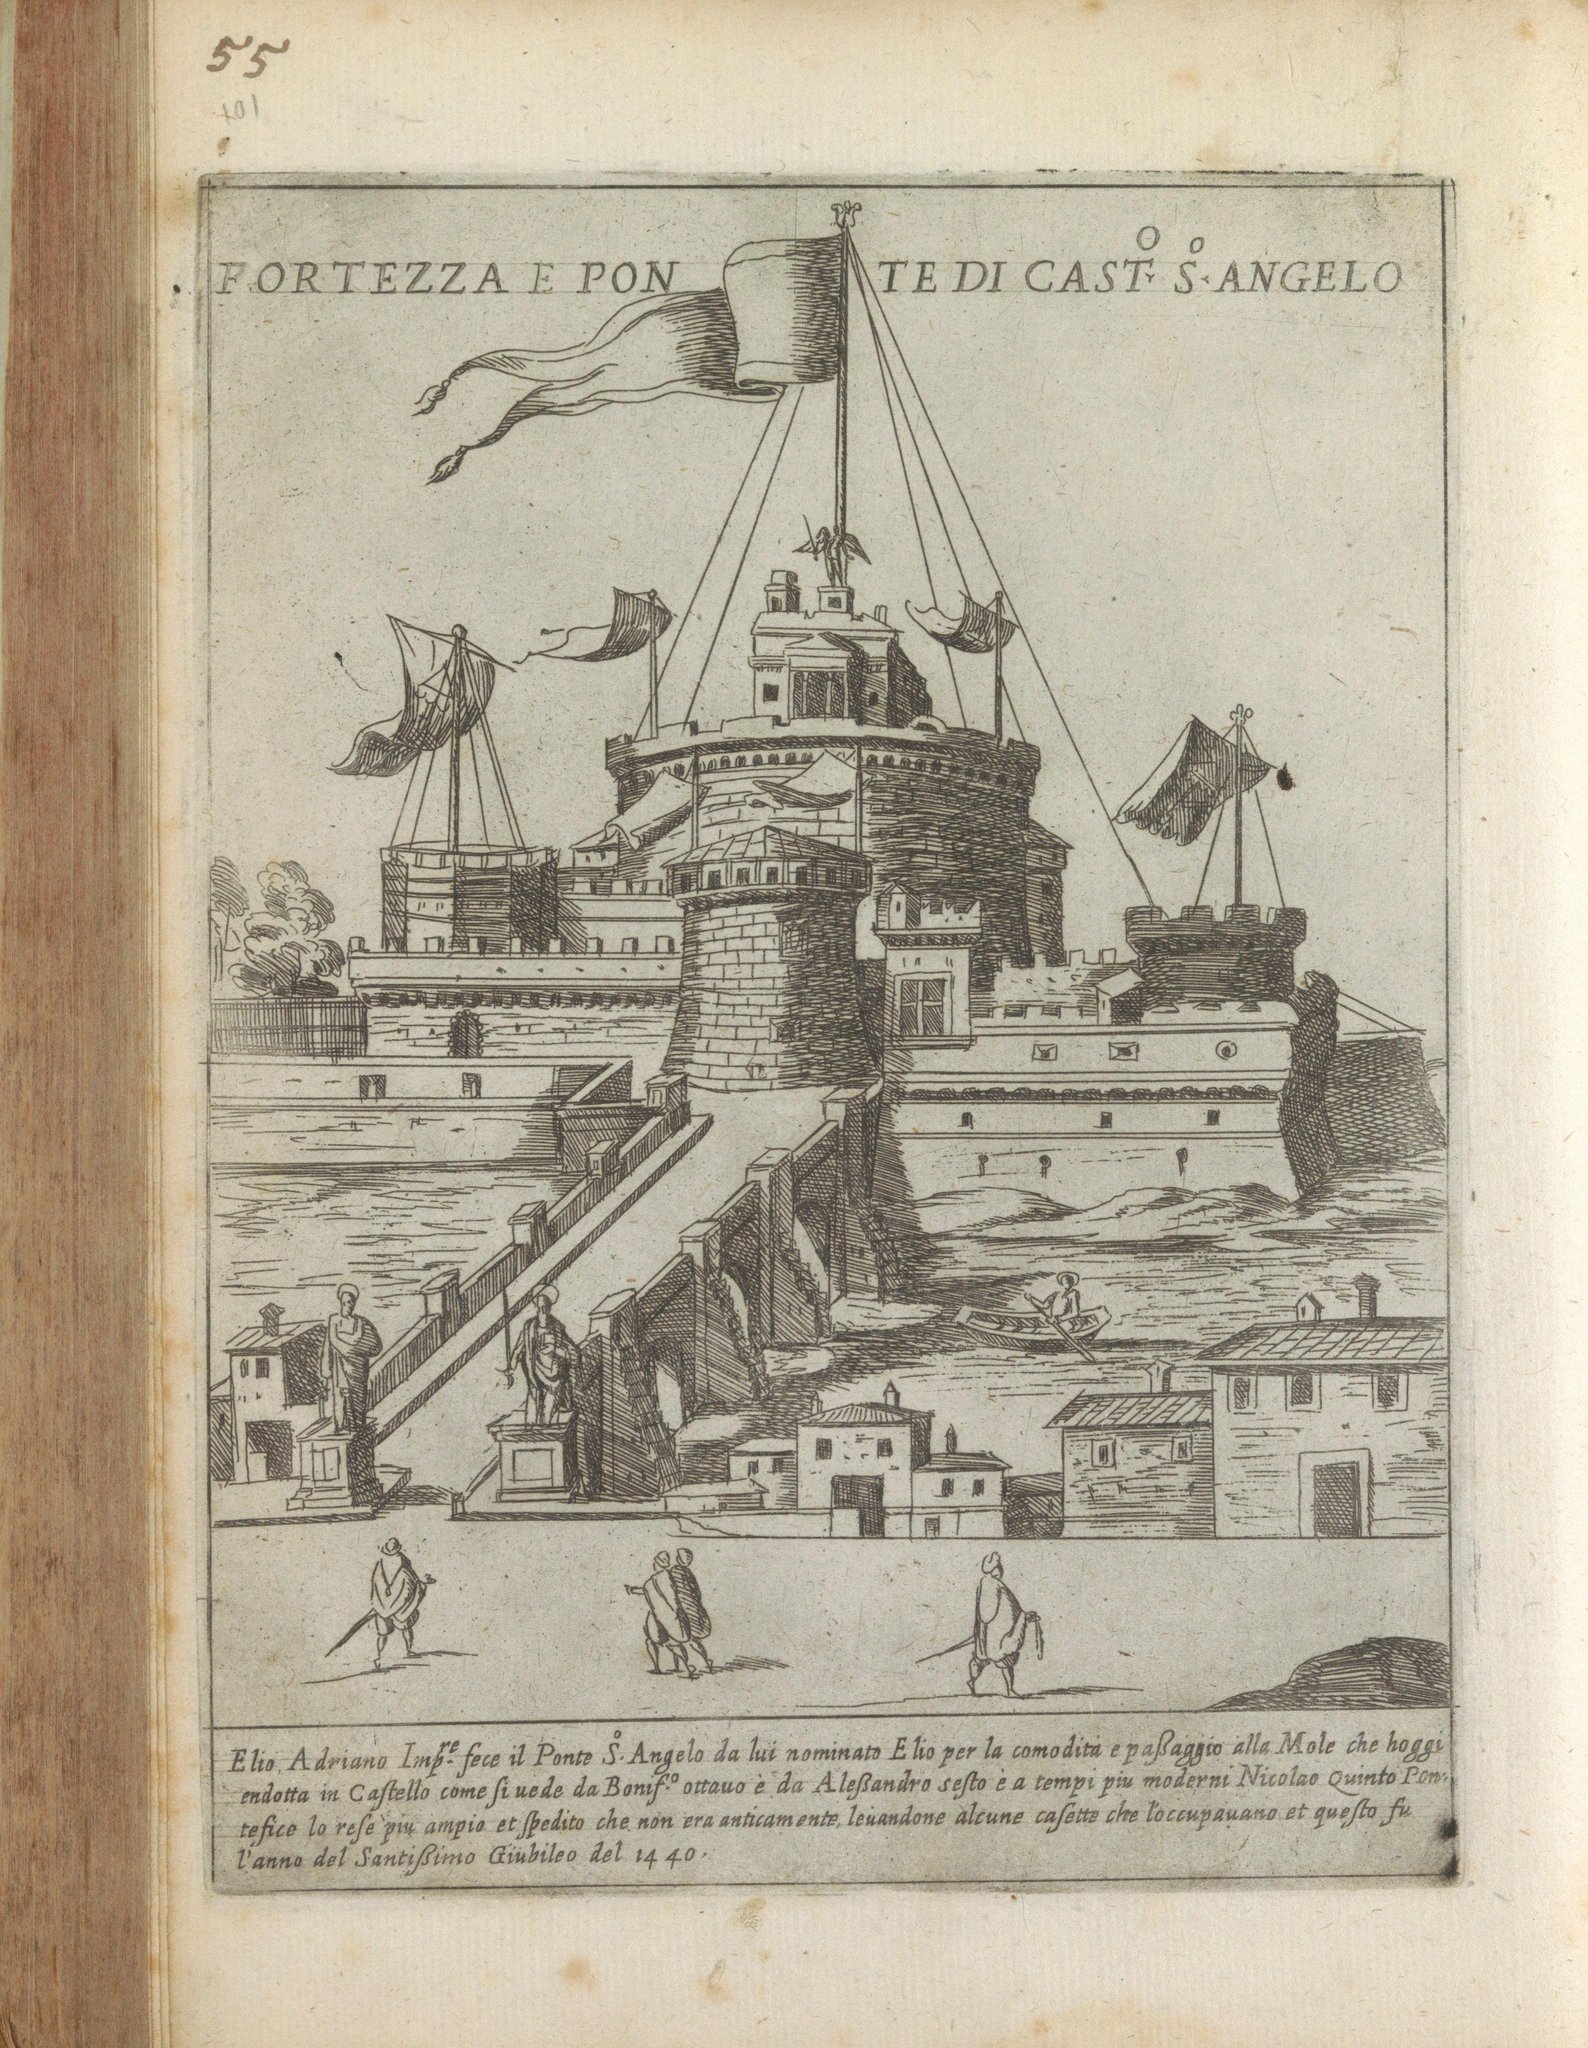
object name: album leaf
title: Ornamenti di fabriche antichi et moderni dell' alma citta di Roma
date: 1576-1618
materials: paper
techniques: etching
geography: rome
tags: fortress, city-view, and landscape with man-made constructions, river, bridge in city across river, canal, etc.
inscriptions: number: ‘55’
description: Tekst in het Italiaans onder de voorstelling. De prent maakt deel uit van een album.